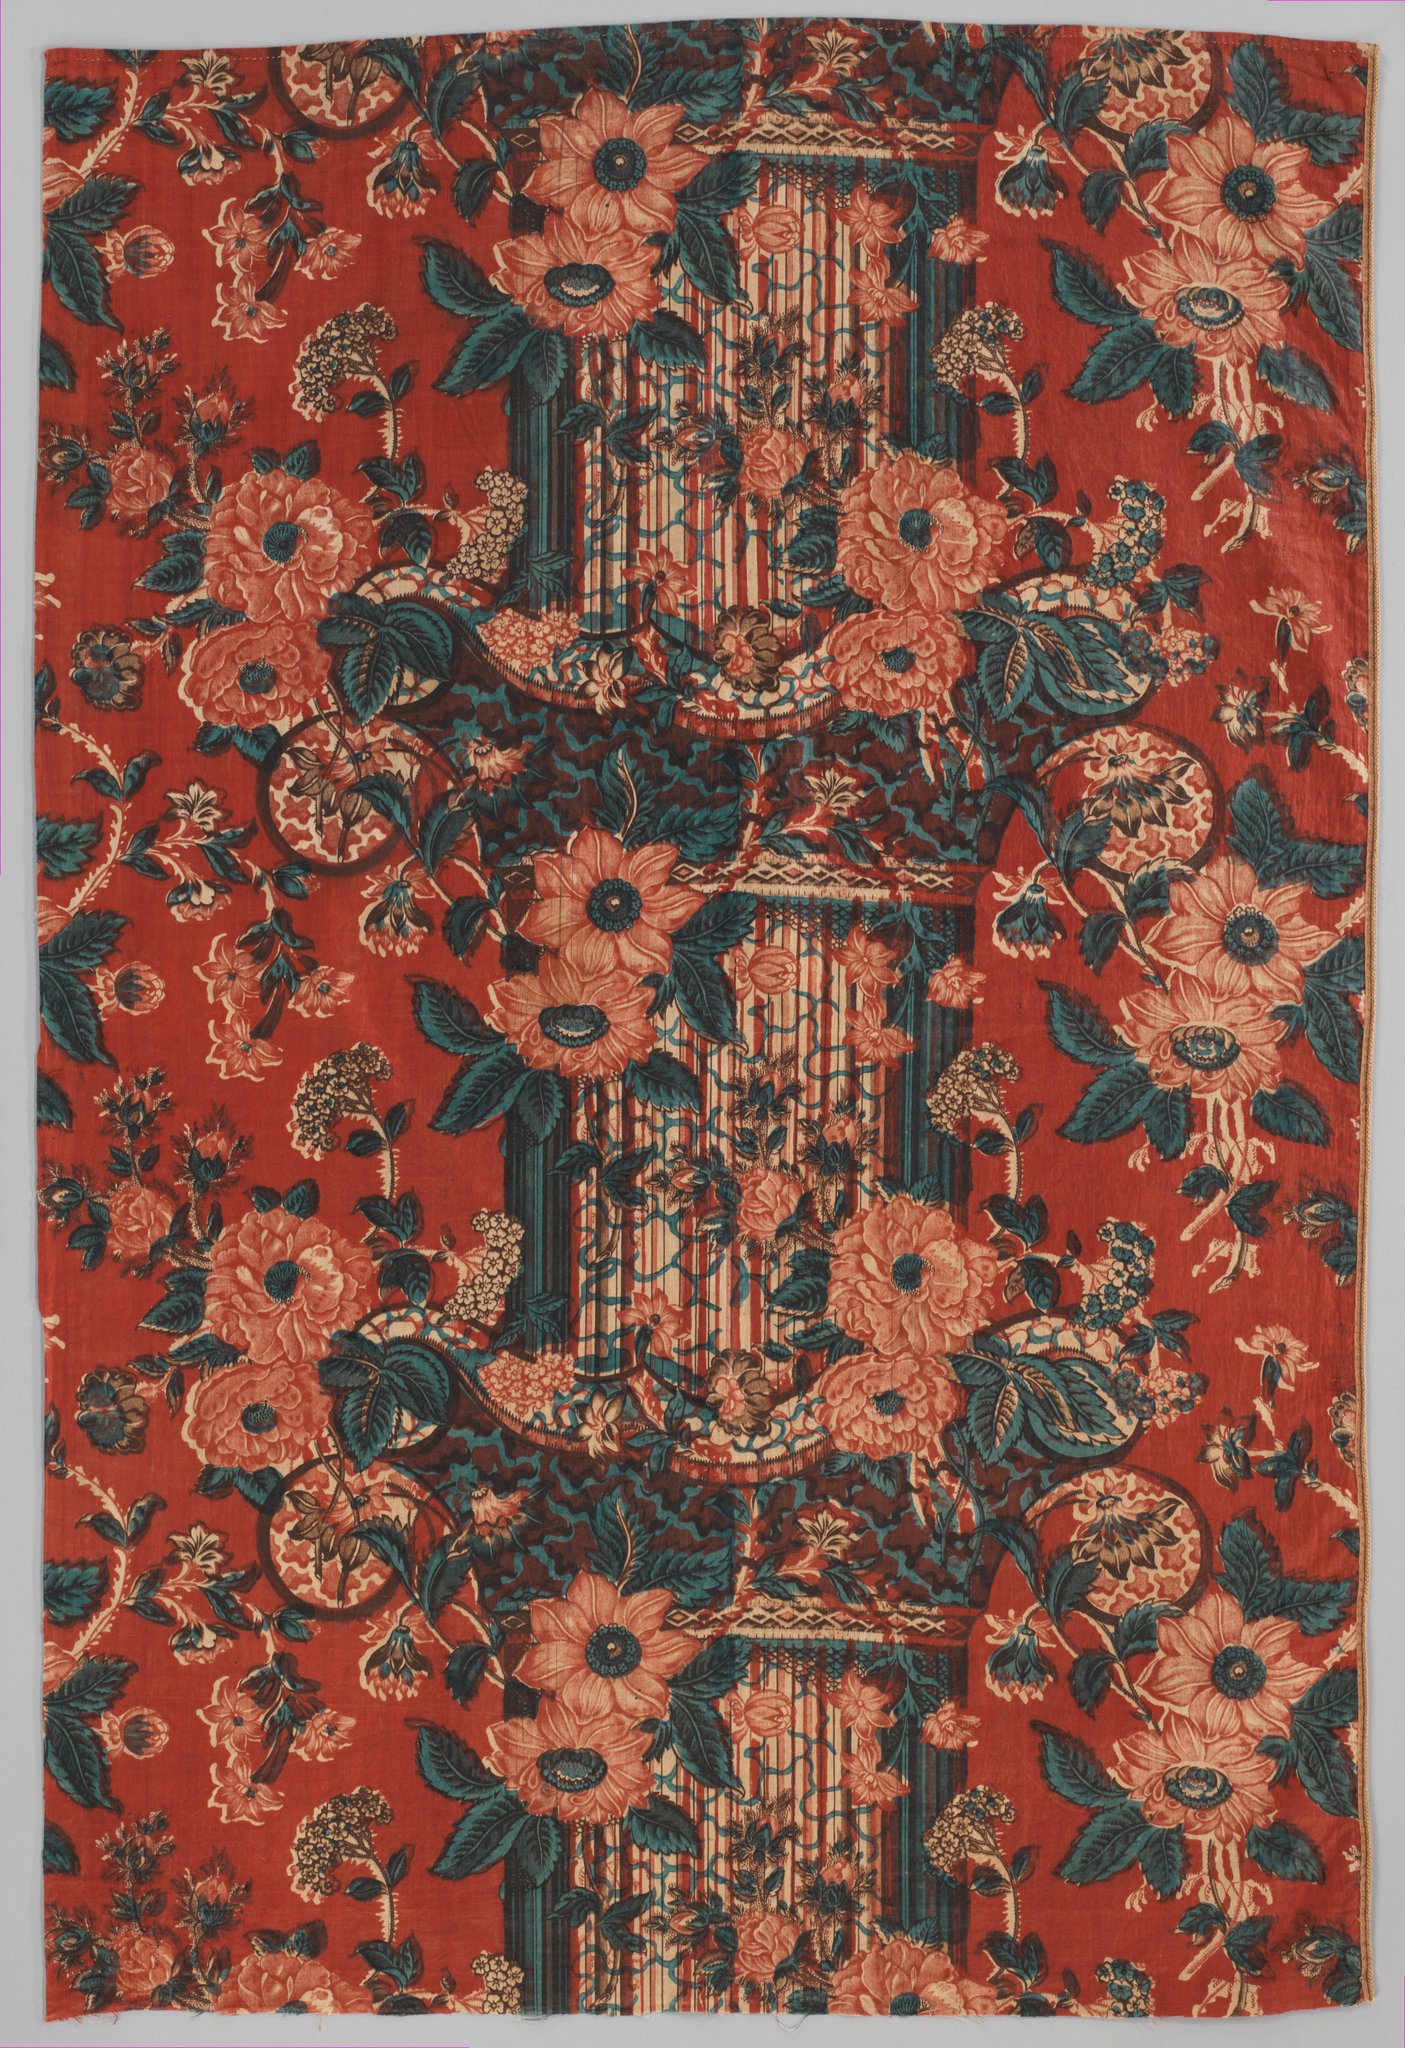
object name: piece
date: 1825-1835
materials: cotton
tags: flowers